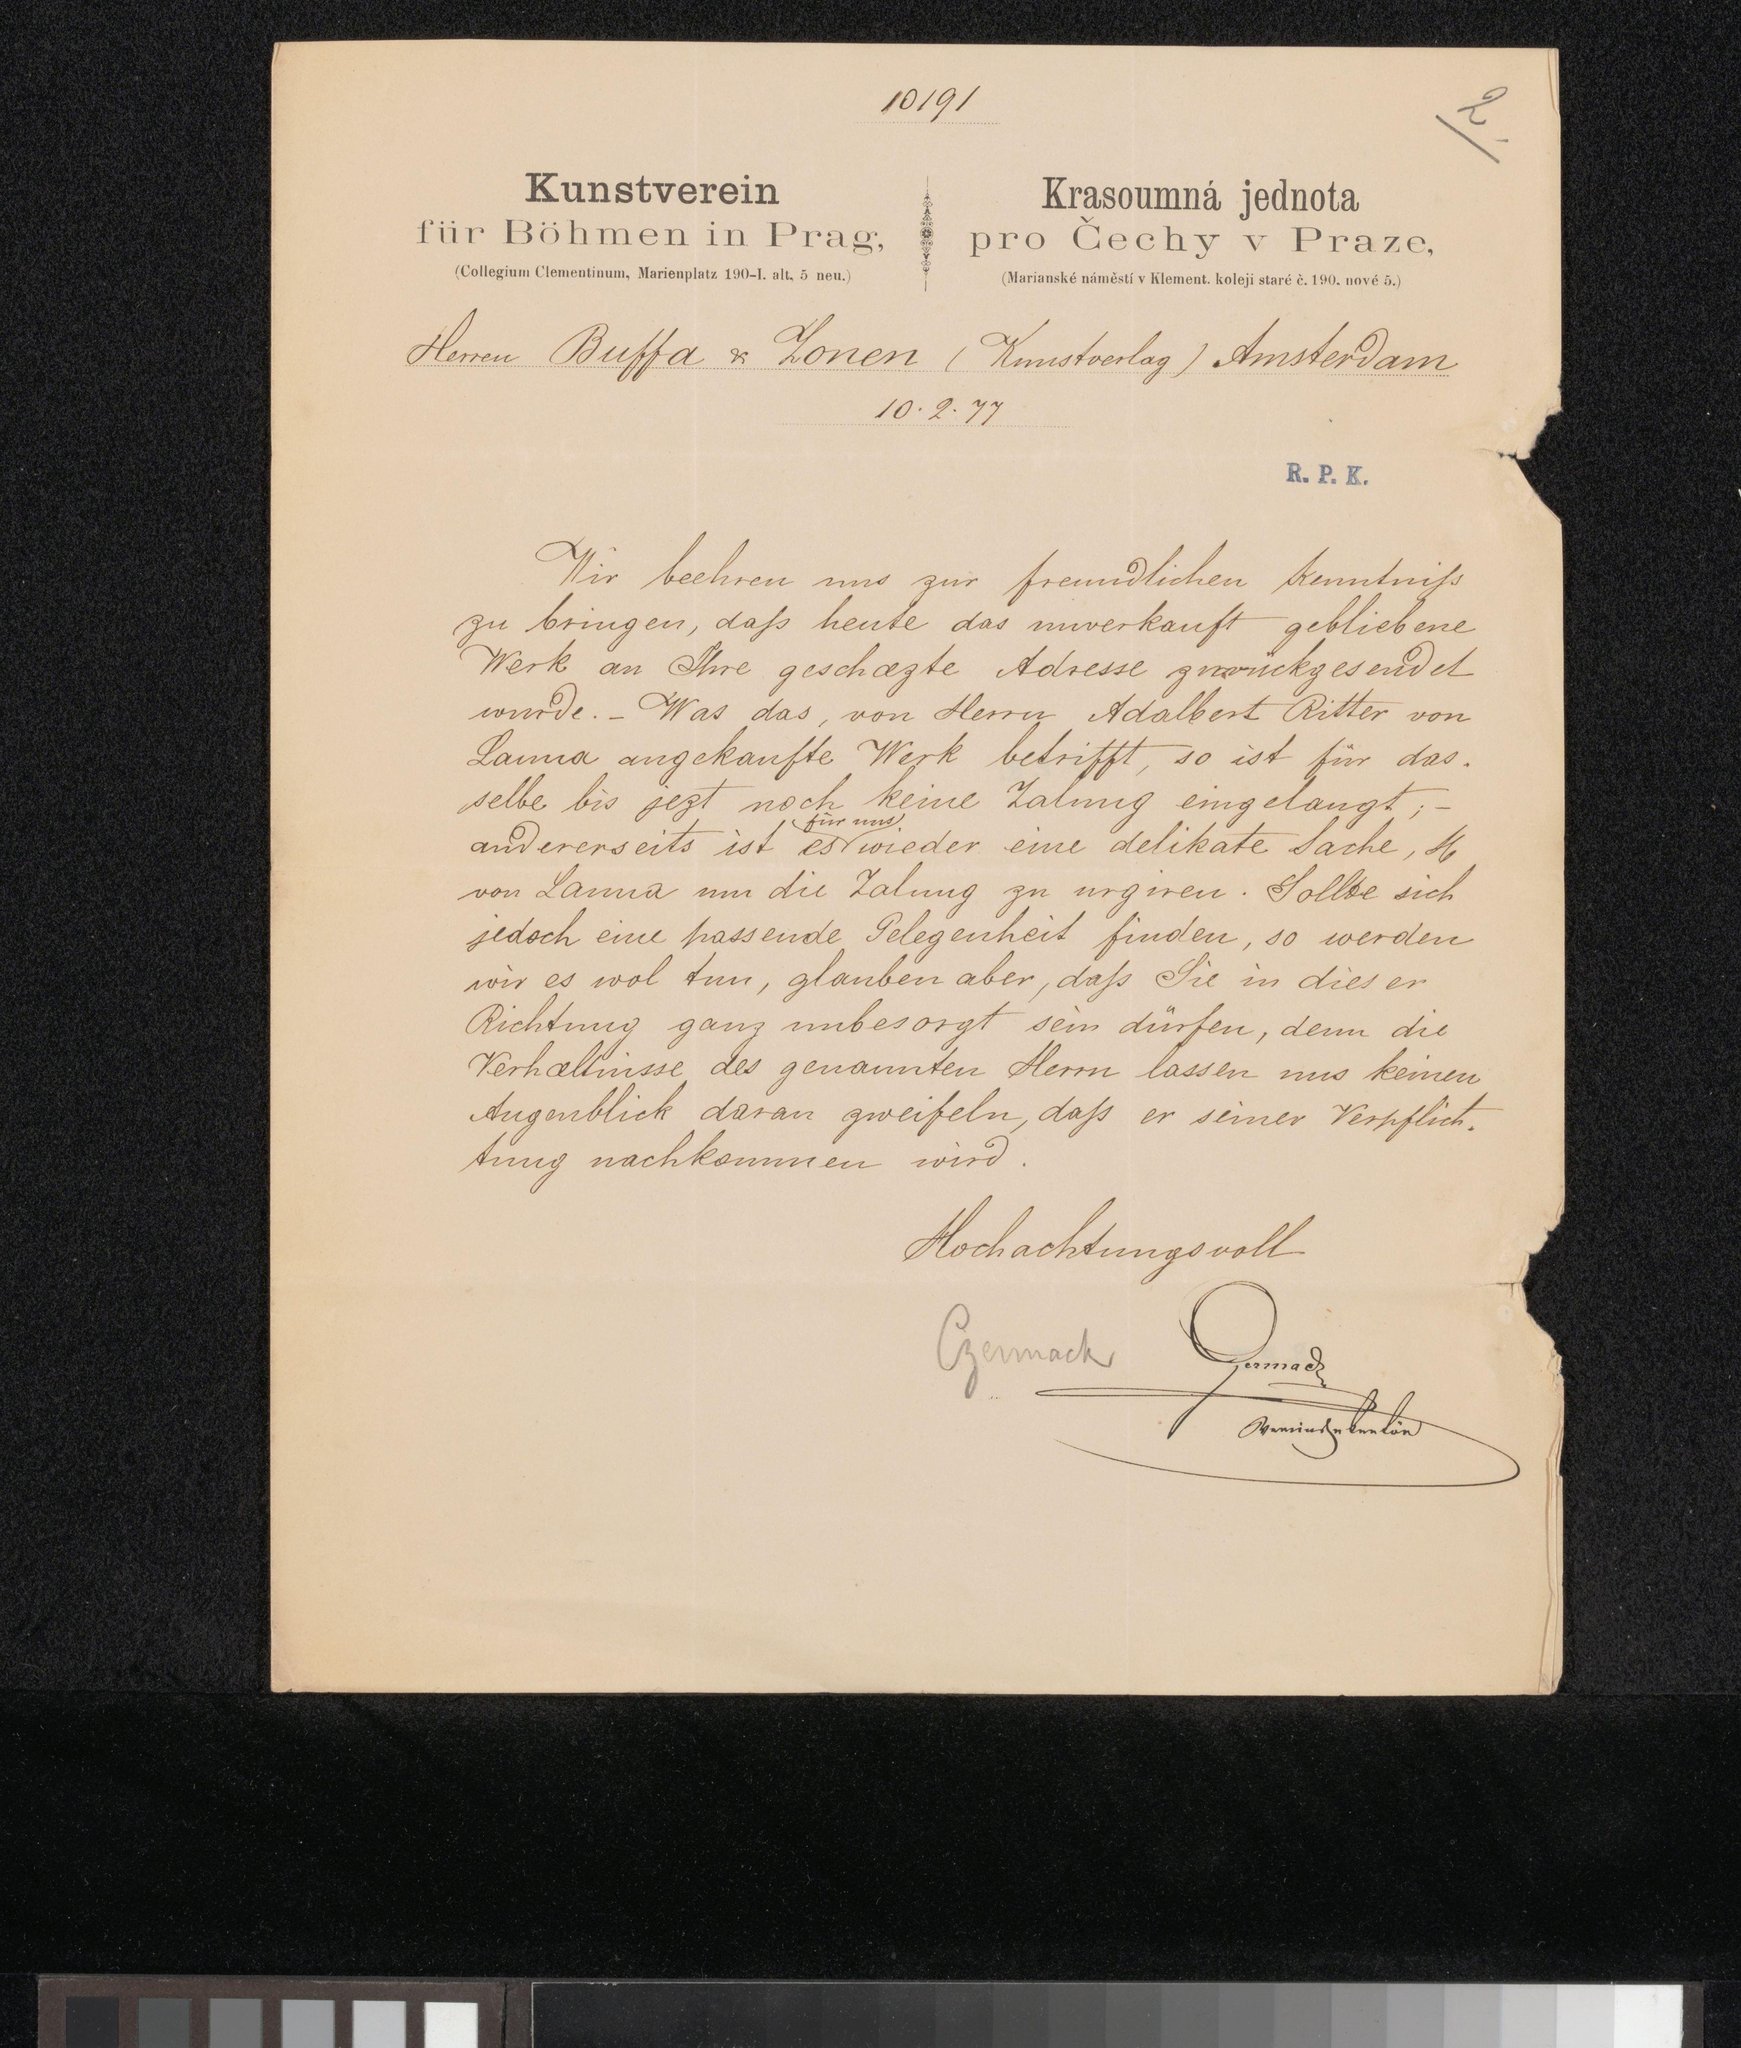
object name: letter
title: Brief aan Frans Buffa en Zonen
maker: alois czermack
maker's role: secretaris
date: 1877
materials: ink, paper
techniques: pen, printing, writing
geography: prague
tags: publisher, art trade, art shop, money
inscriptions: collector's mark: Lugt 2233